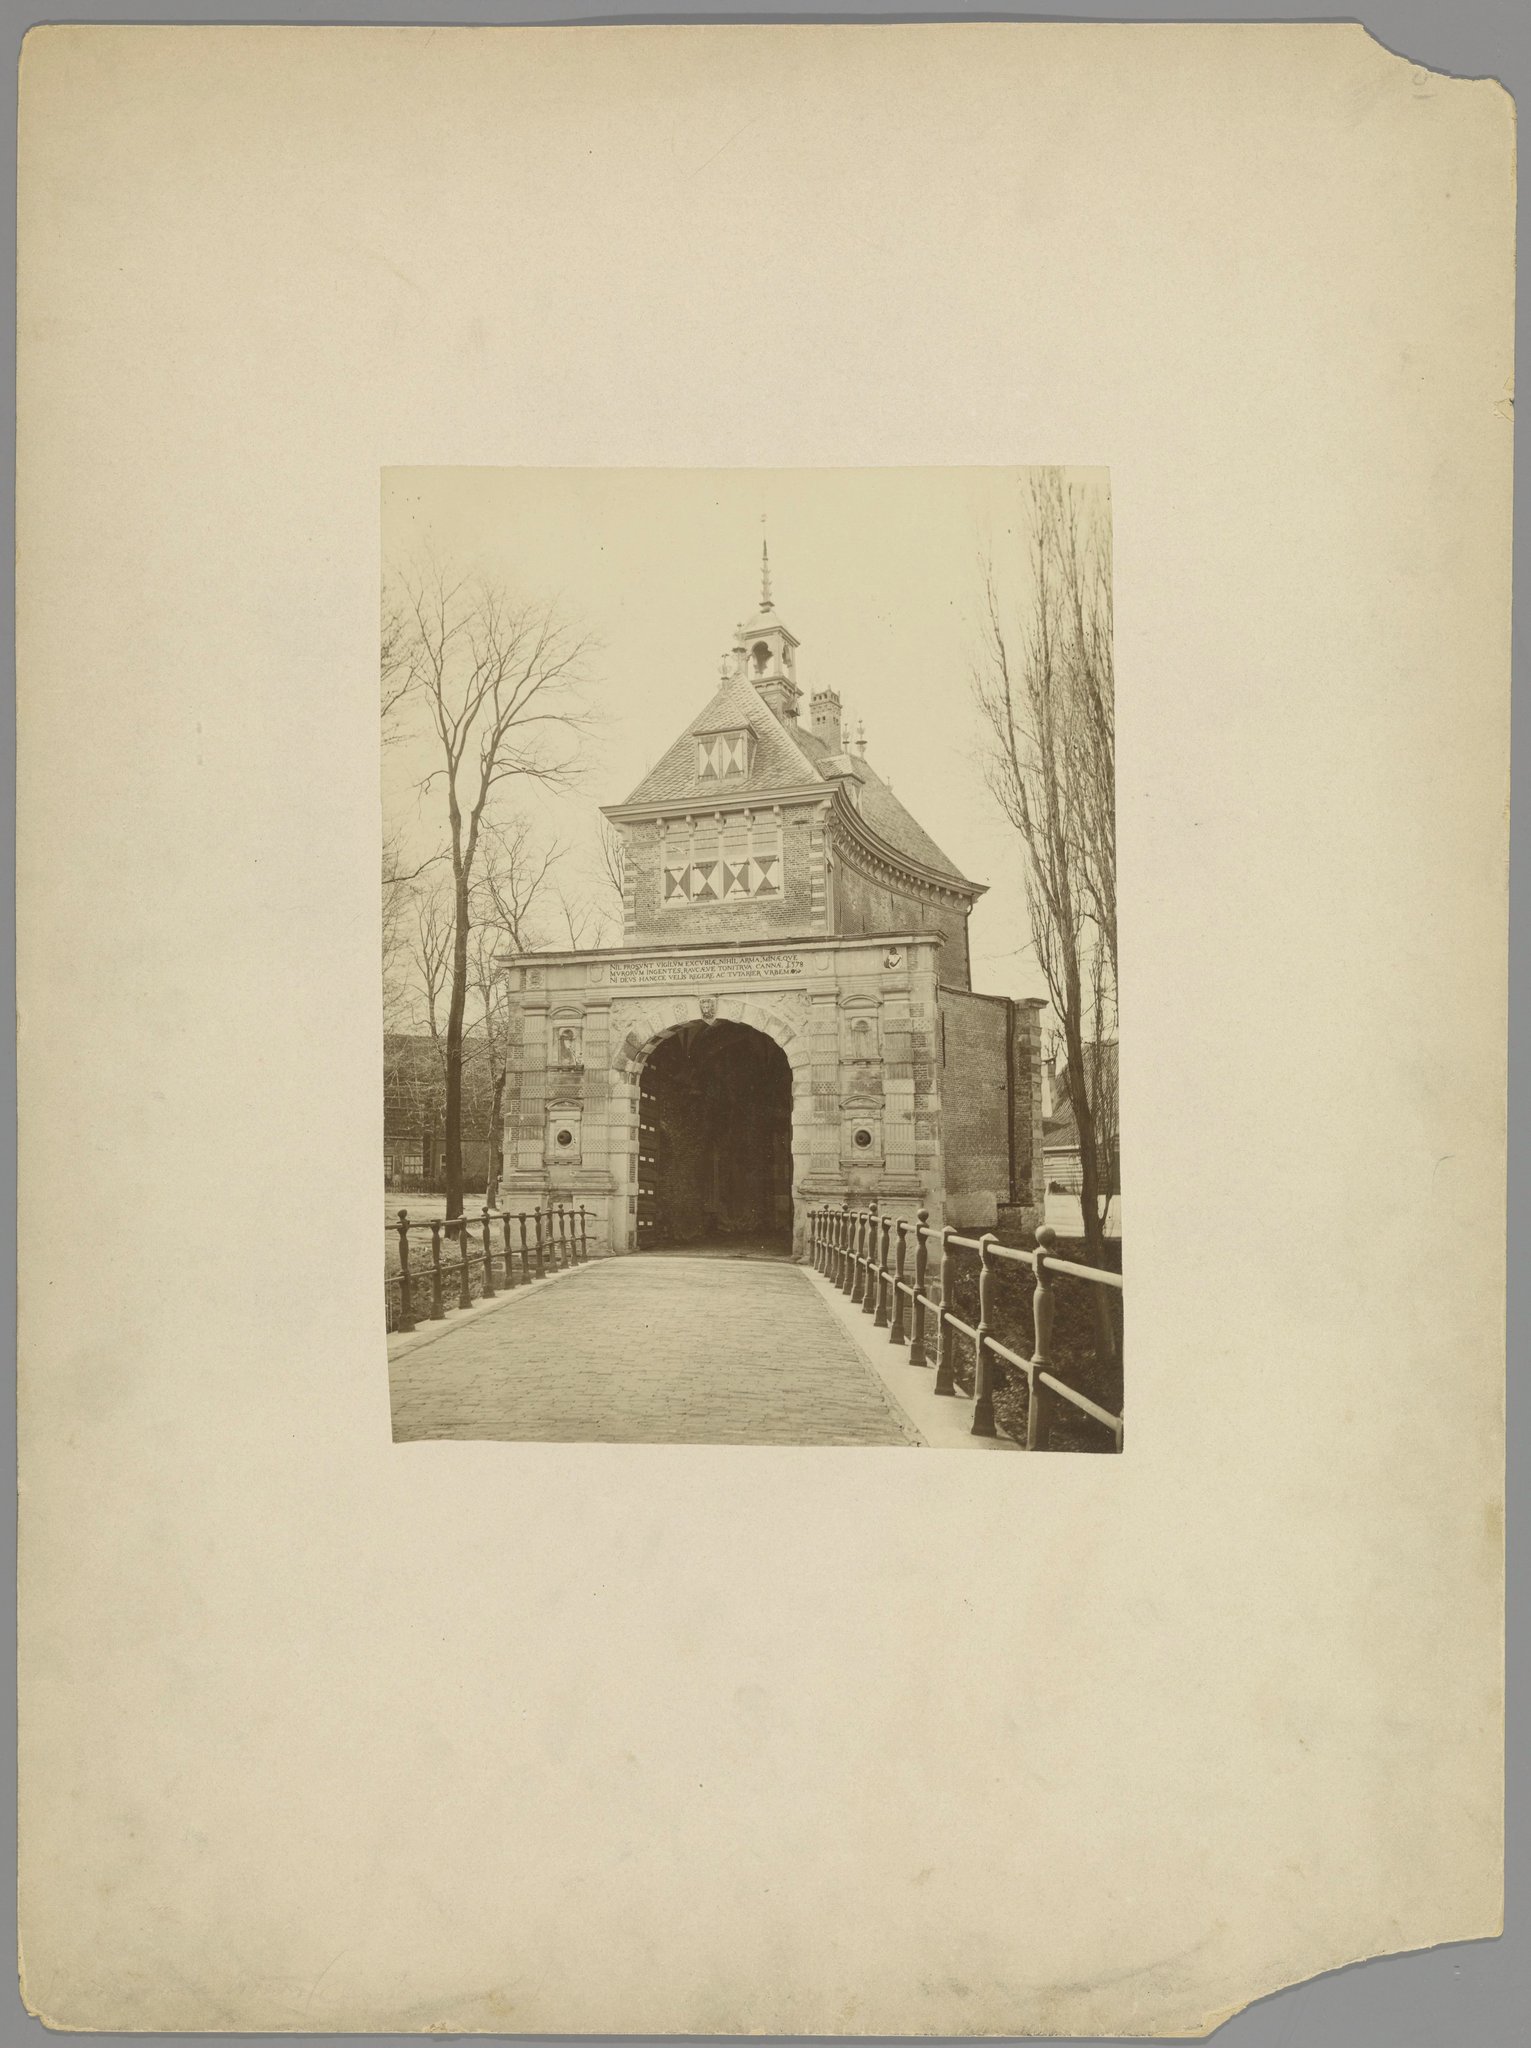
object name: photograph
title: Oosterpoort te Hoorn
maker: Anonymous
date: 1875-1900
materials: cardboard, photographic support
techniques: albumen print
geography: hoorn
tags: bridge, city-gate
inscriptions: collector's mark: Lugt 3937